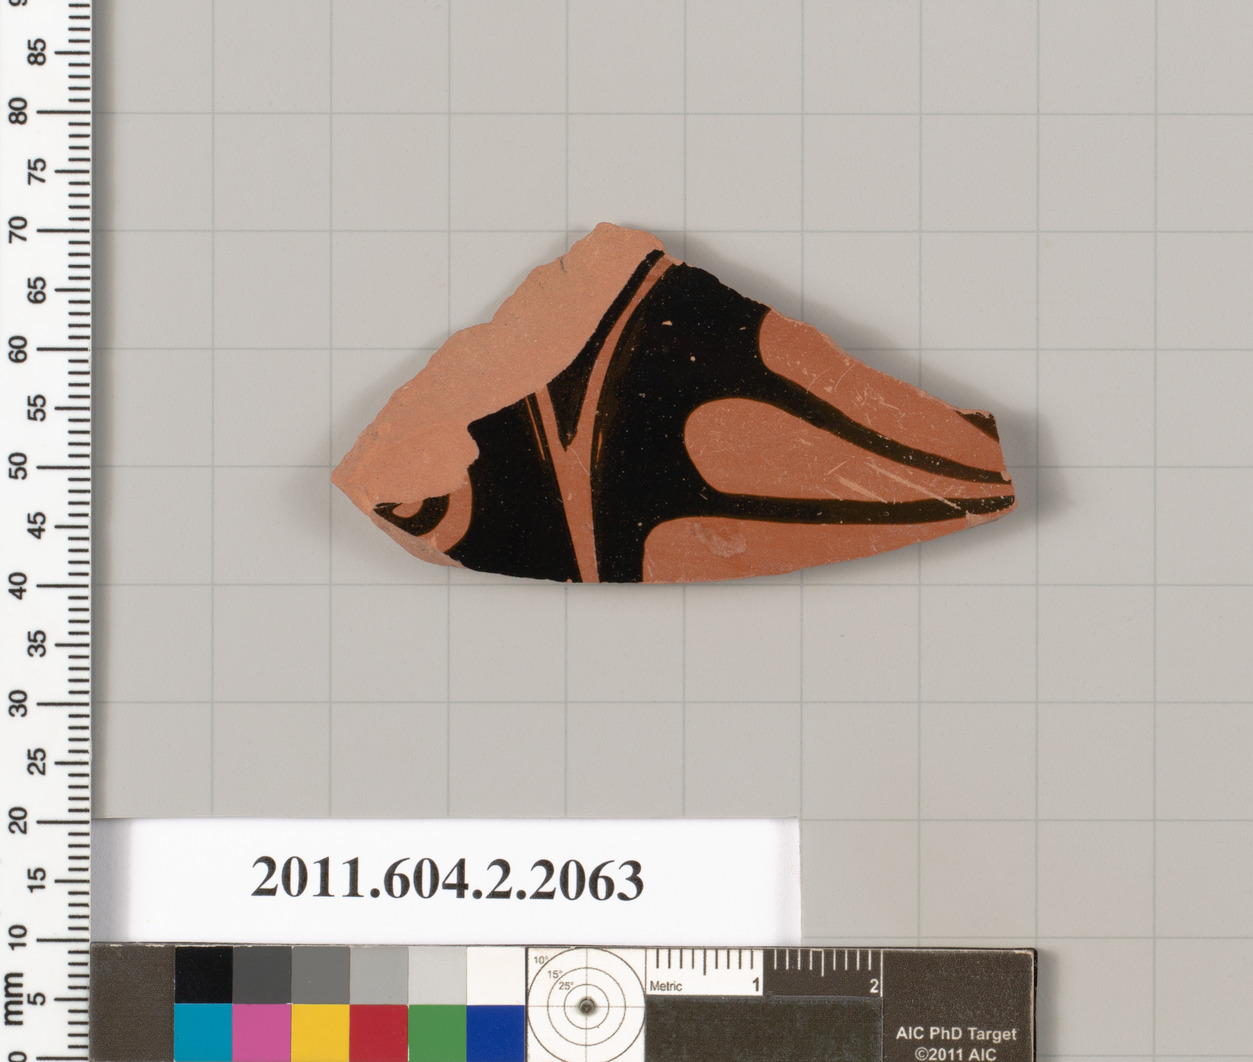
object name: stamnos fragment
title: Terracotta fragment of a stamnos (jar)?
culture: greek, attic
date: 490-470 BCE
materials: terracotta